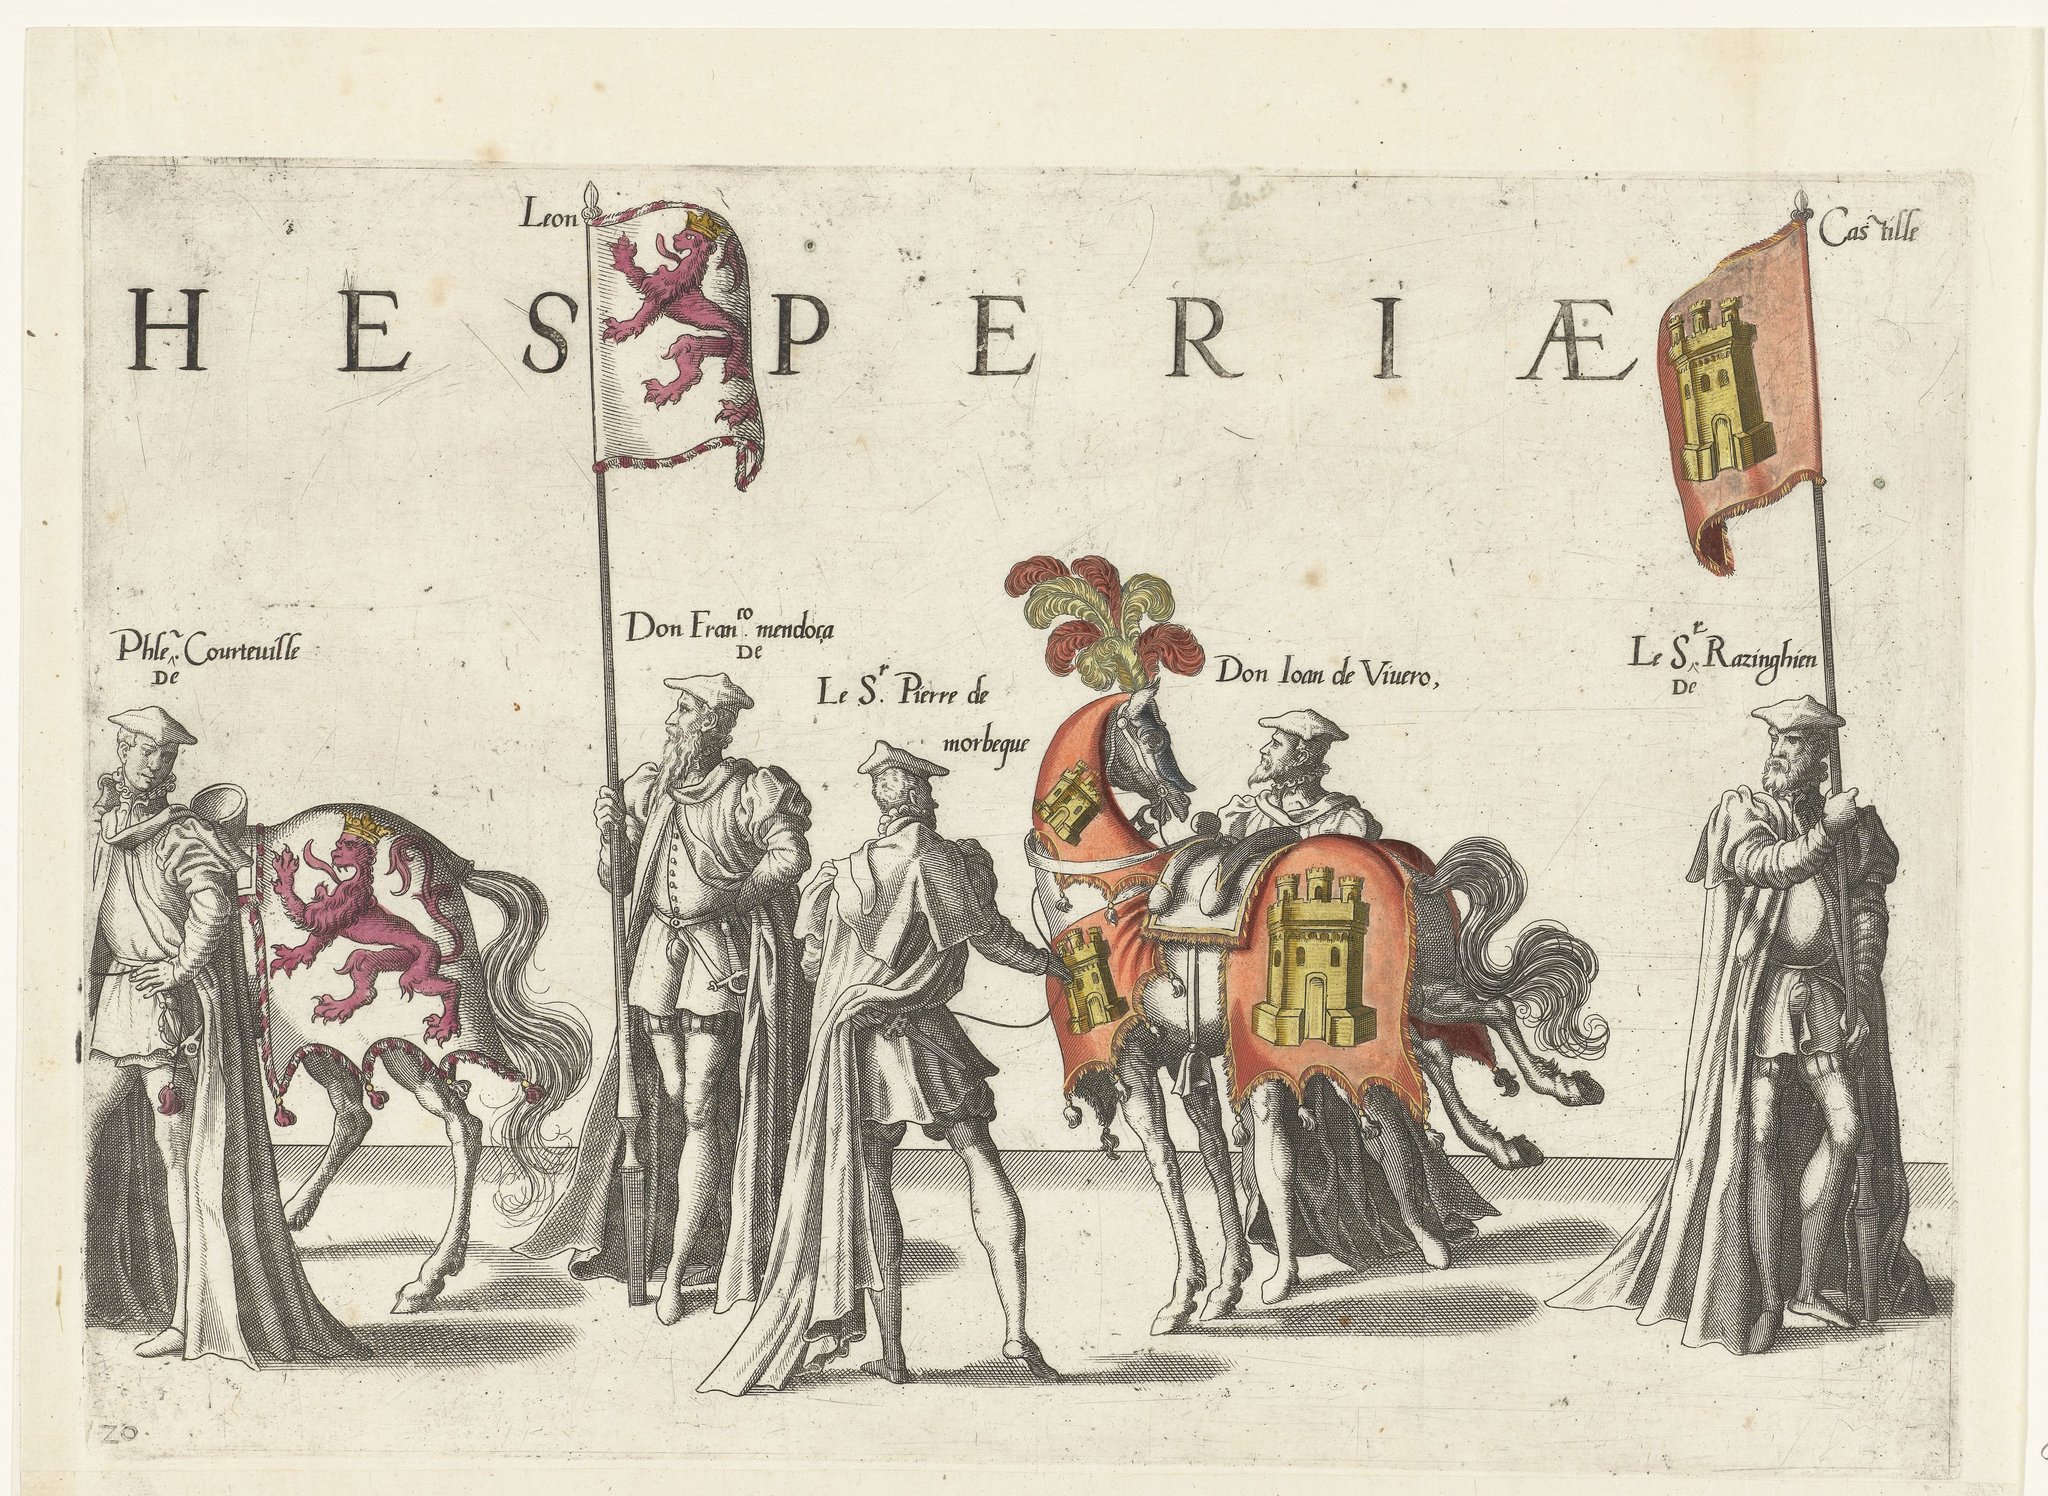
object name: print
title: Begrafenisoptocht van keizer Karel V, 1558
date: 1559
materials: paper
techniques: engraving, etching, hand coloring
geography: southern netherlands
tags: ghent, charles v (holy roman emperor and king of spain), cortege, funeral procession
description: Vijf deelnemers aan de optocht, paarden en de vaandels met de wapens van Castilla en León. Onderdeel van de prentreeks van de Begrafenisoptocht van keizer Karel V op 29 december 1558 te Brussel.